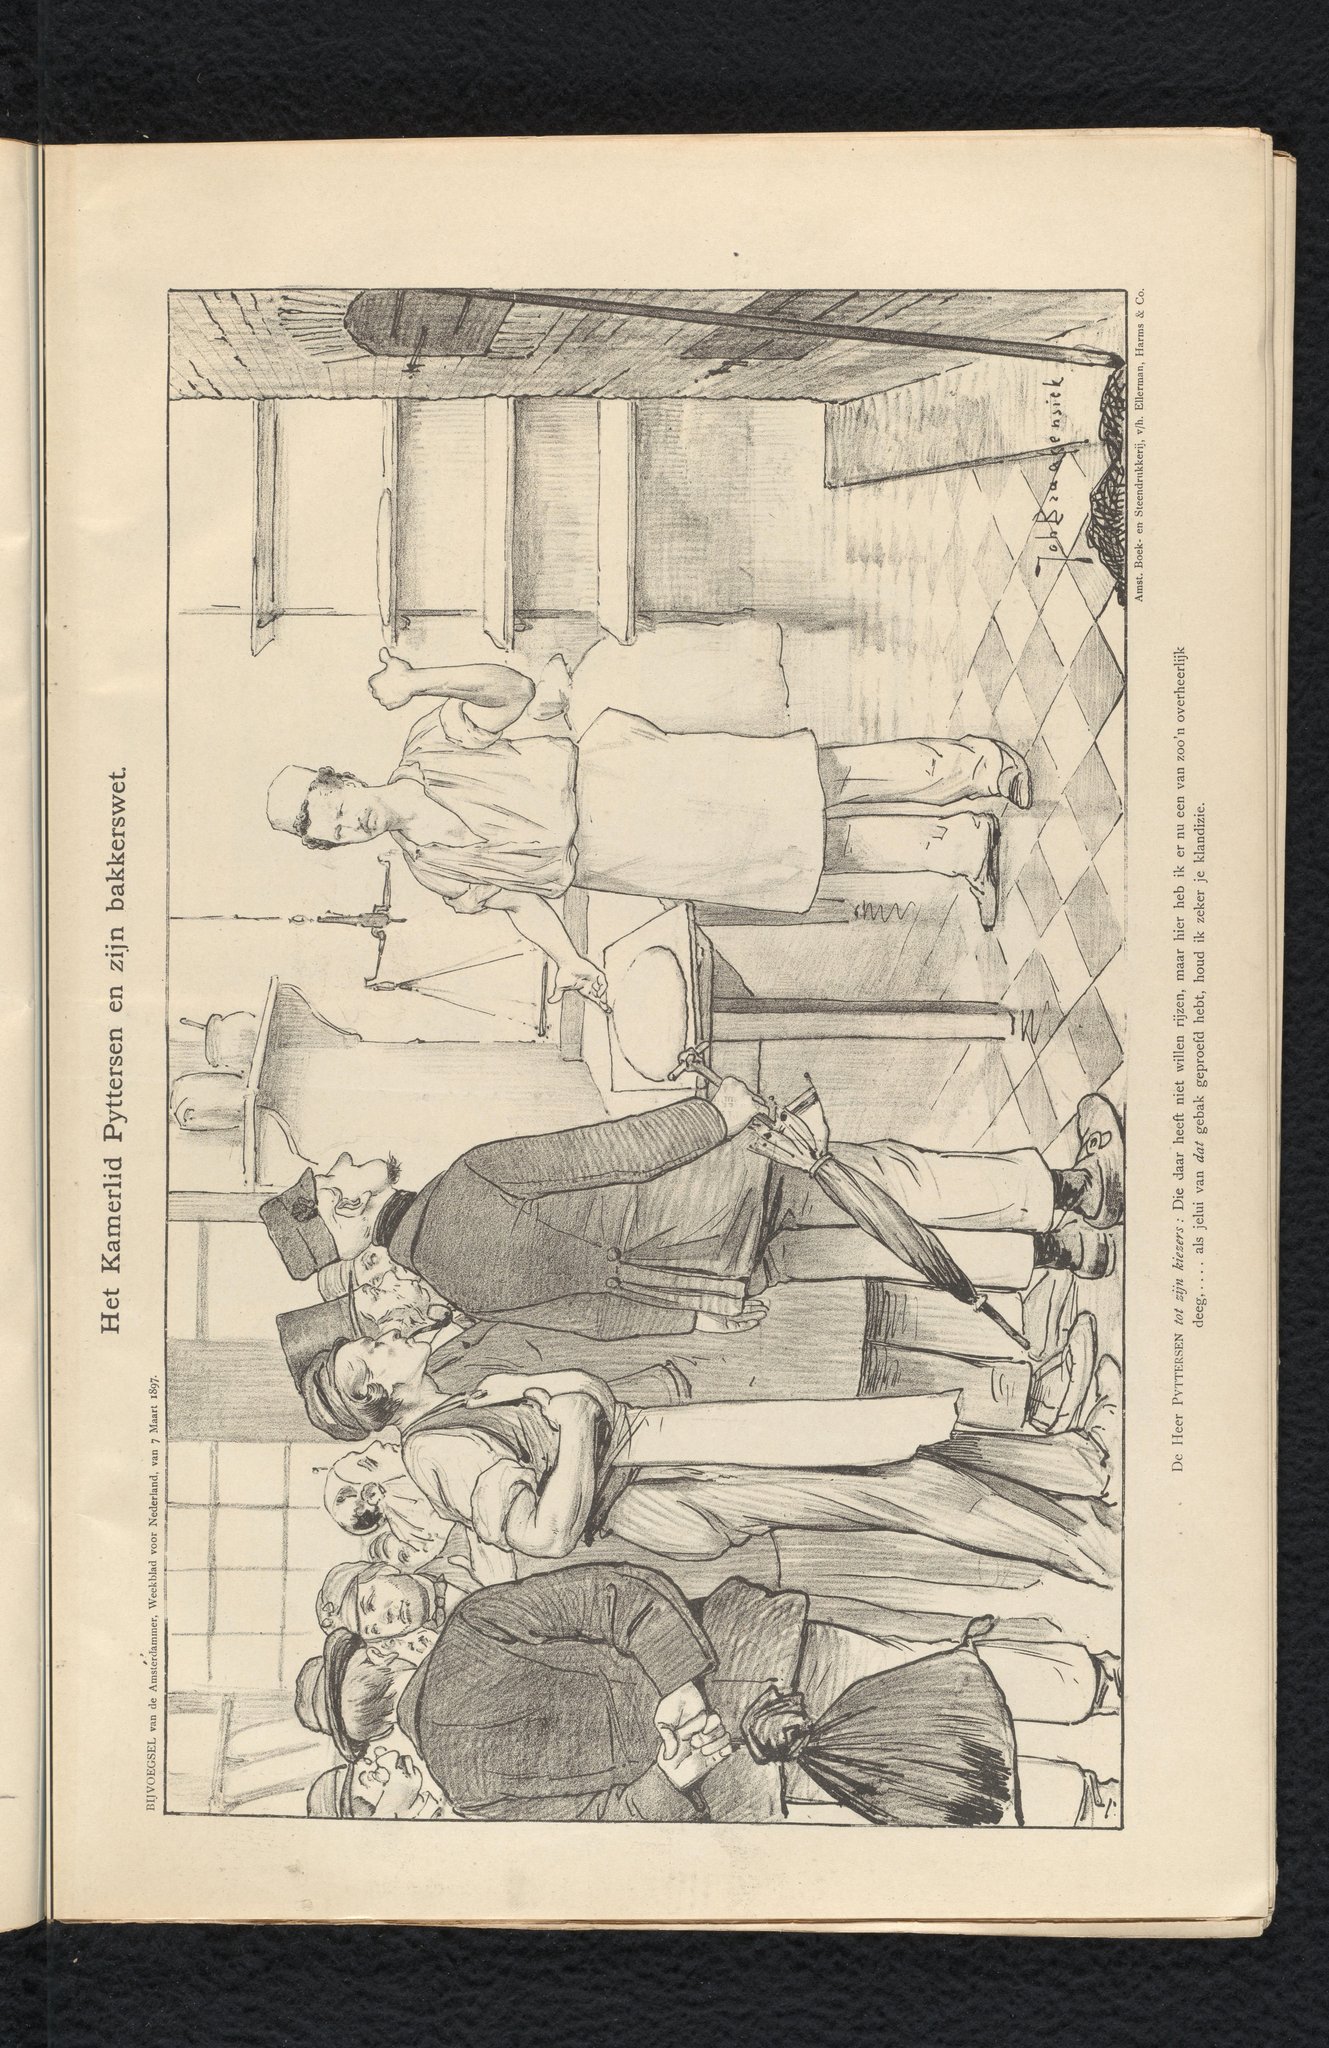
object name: cartoon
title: Het Kamerlid Pyttersen en zijn bakkerswet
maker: johan braakensiek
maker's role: draughtsman, print maker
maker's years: 1858-1940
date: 1897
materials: paper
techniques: lithograph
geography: netherlands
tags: baker, bread, cake, pastry, etc., political caricatures and satires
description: Kamerlid Hendrik Pyttersen Tzn. richt zich tot zijn verzamelde klanten, zijn kiezers, in de bakkerij. Pyttersen diende een initiatiefvoorstel in over verbetering van de arbeidstoestanden in bakkerijen.